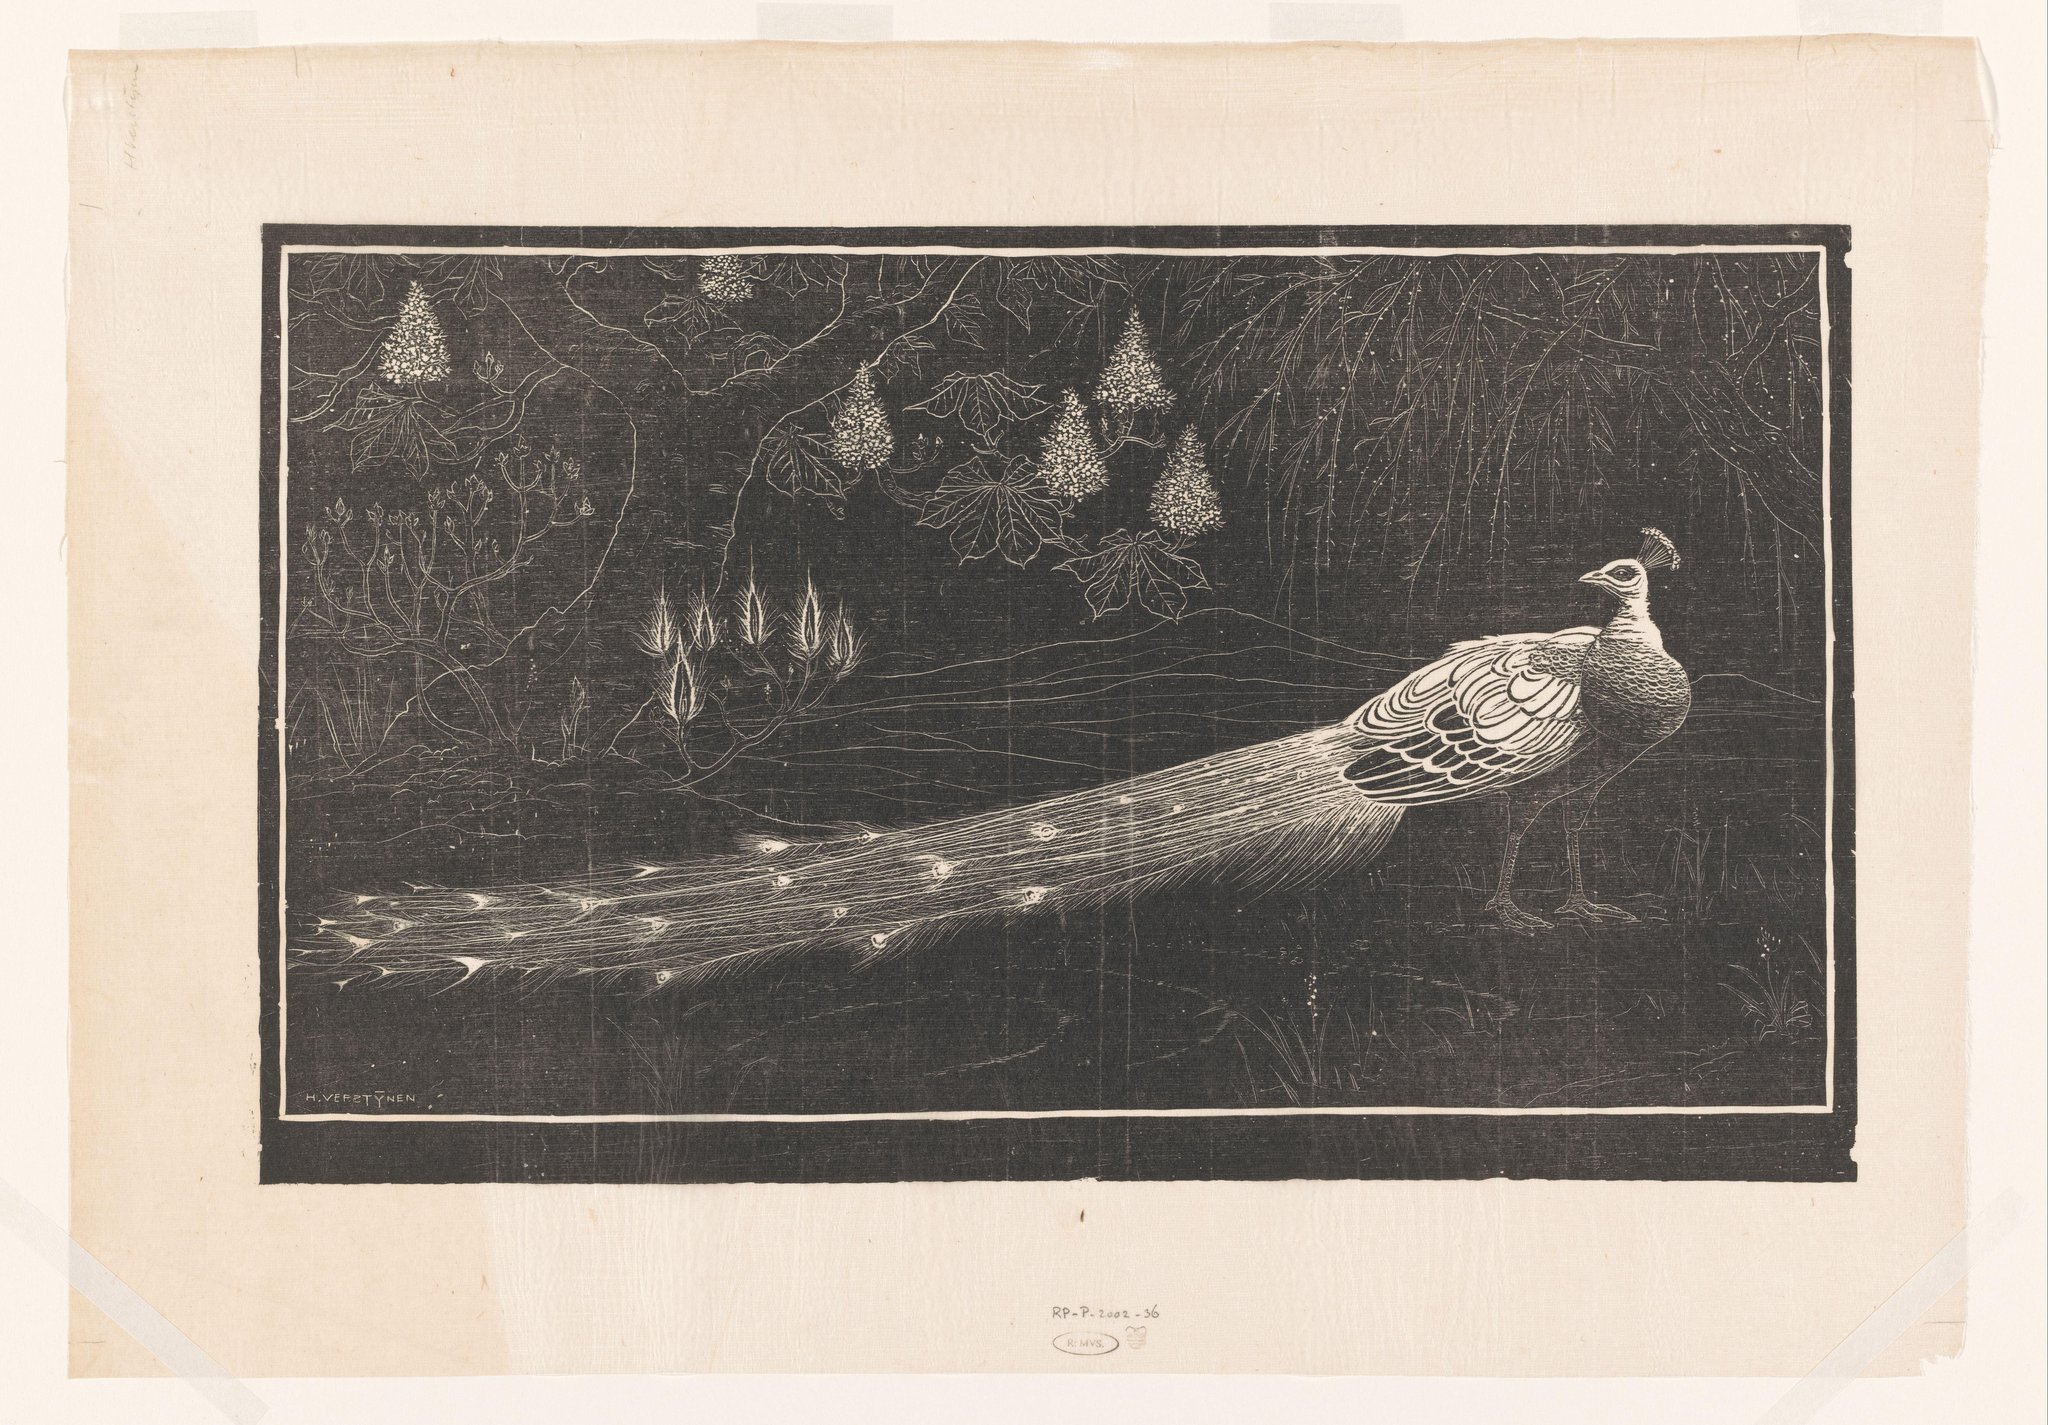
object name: print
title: Pauw in landschap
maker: henri verstijnen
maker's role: draughtsman, print maker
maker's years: 1882-1940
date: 1892-1940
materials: paper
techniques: woodcut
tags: ornamental birds: peacock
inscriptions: collector's mark: Lugt 2760, collector's mark: Lugt 2228